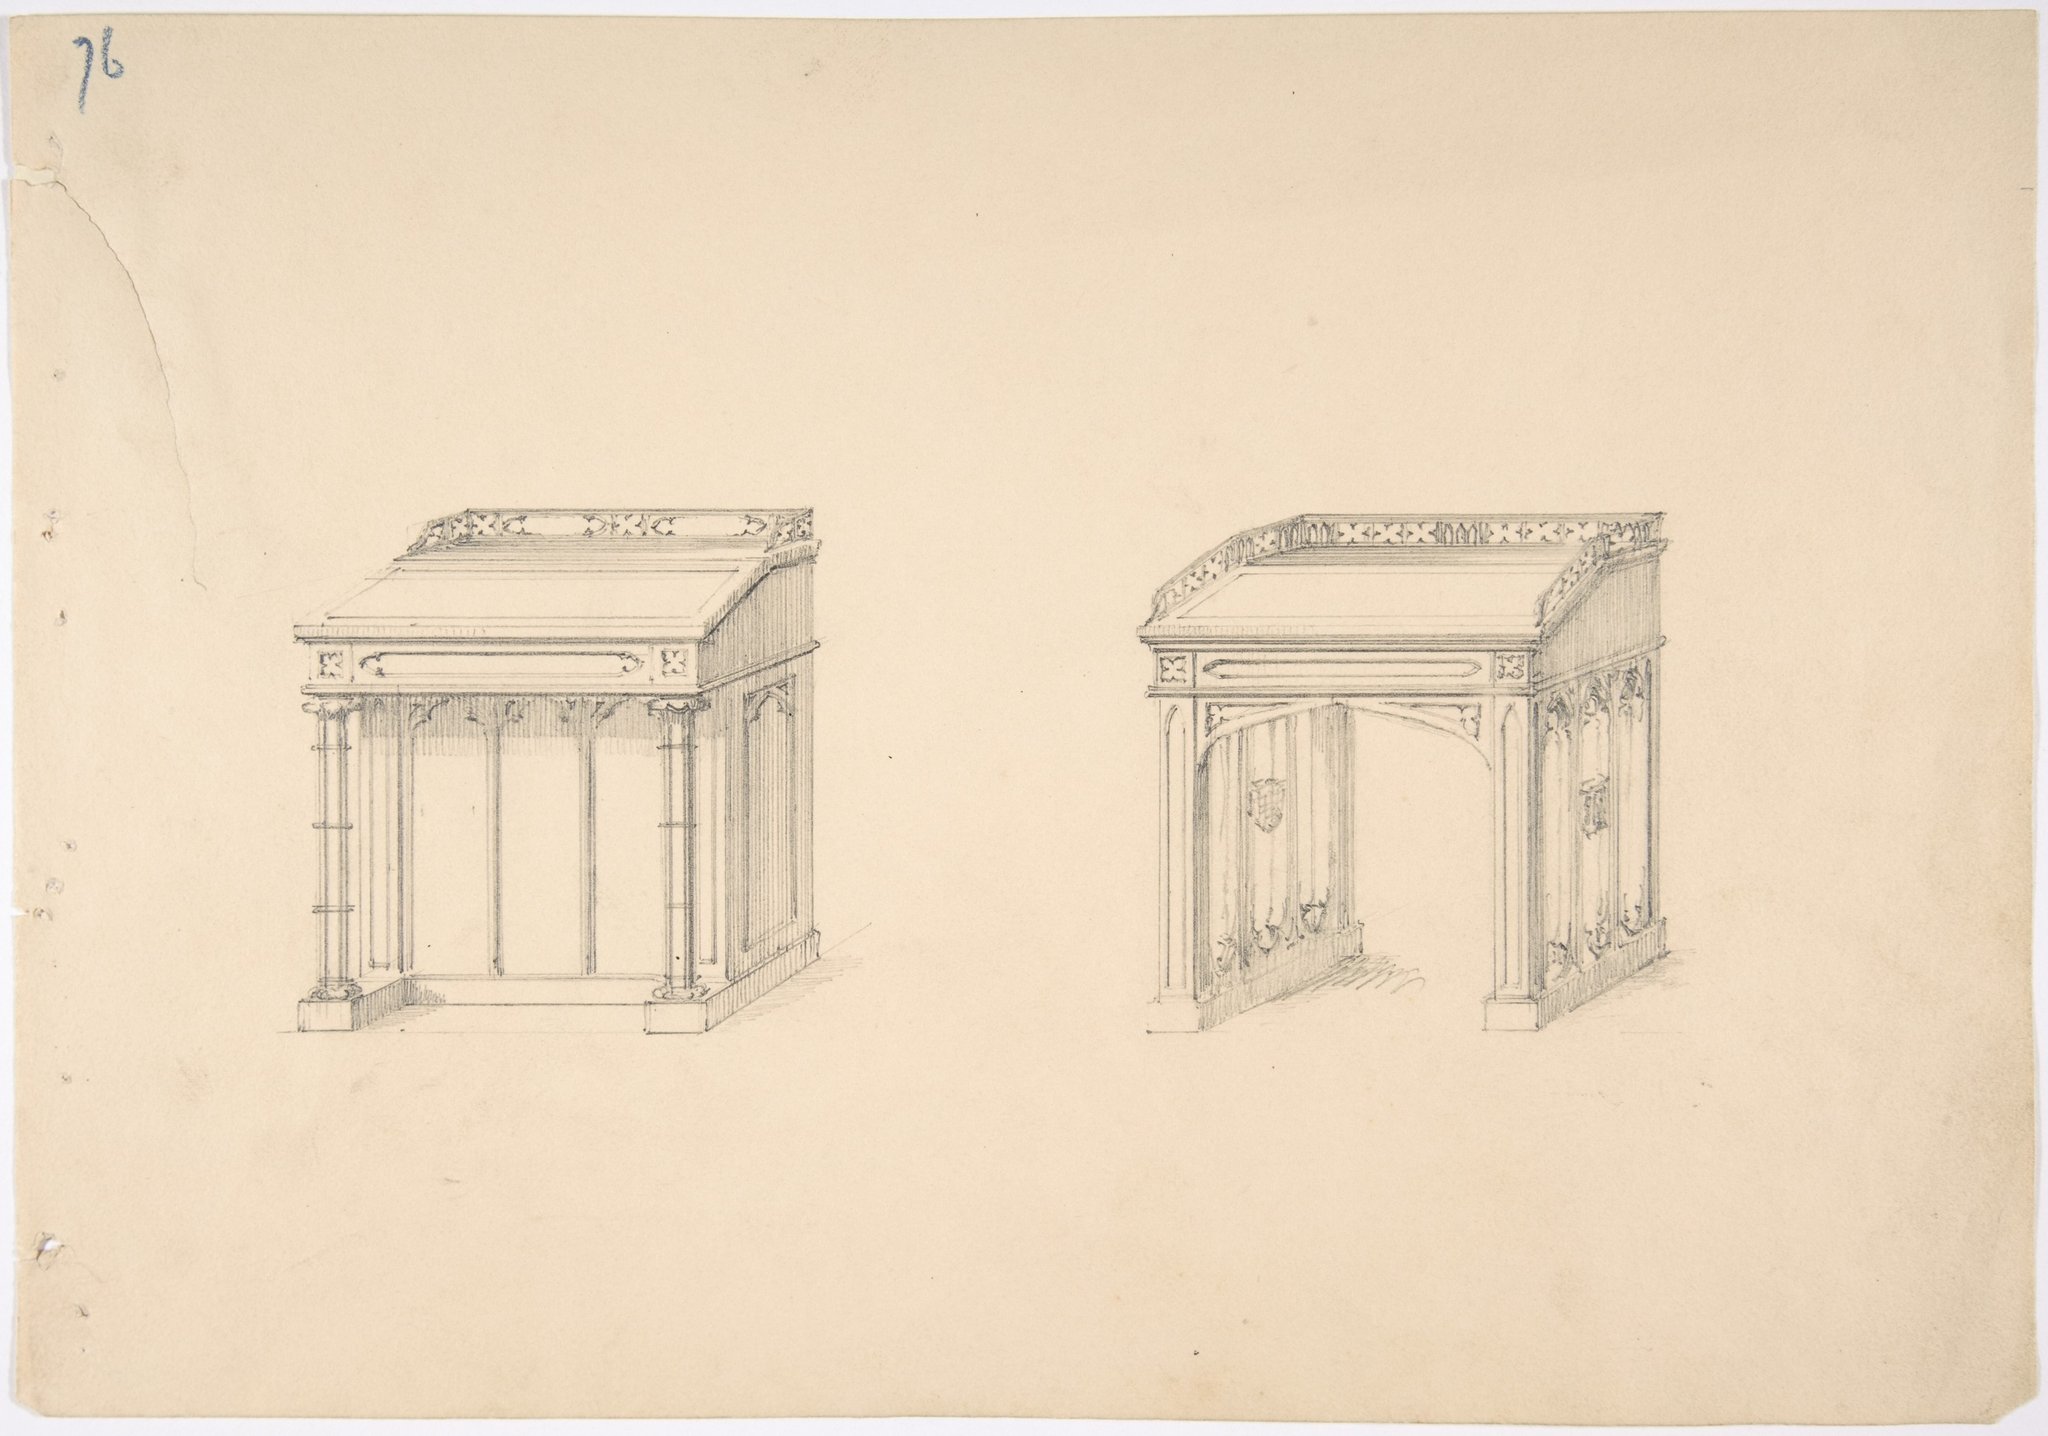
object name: drawing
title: Design for Two Gothic Desks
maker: anonymous, british, 19th century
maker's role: artist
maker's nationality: british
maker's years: 1800-1900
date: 1801-1833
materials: graphite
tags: desks